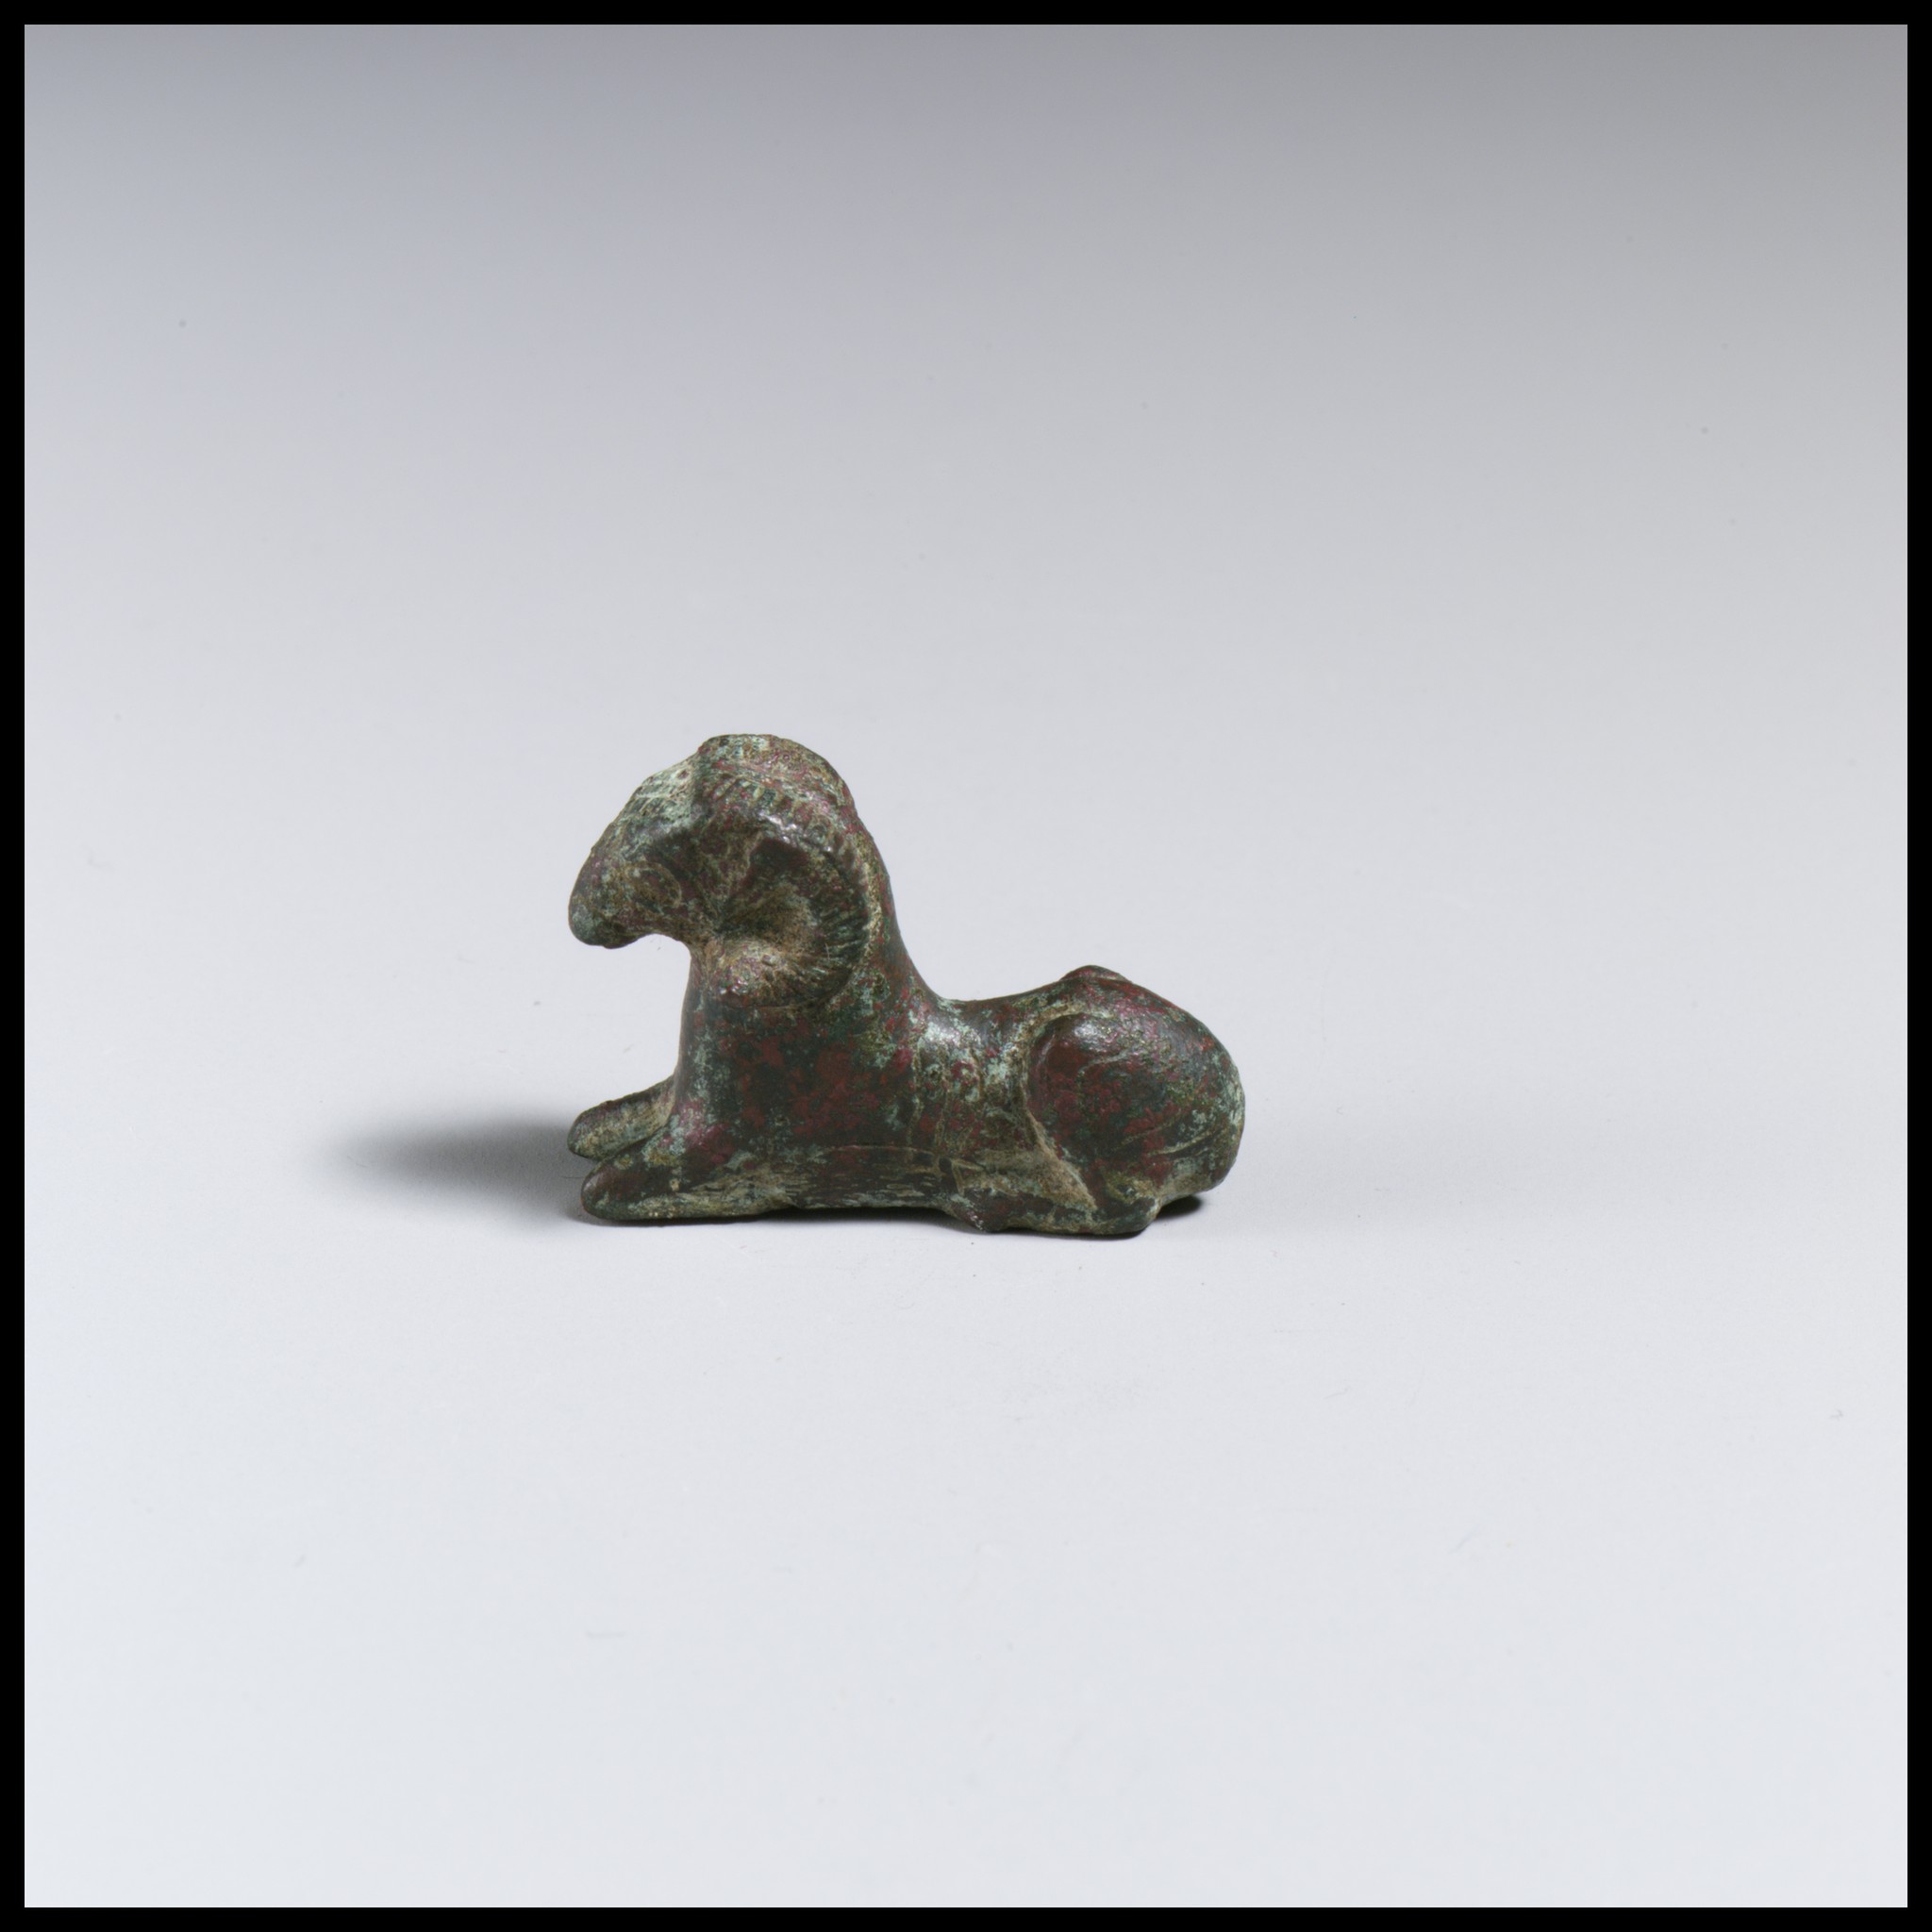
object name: statuette of a ram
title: Bronze statuette of a ram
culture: etruscan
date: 600-501 BCE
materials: bronze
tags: rams